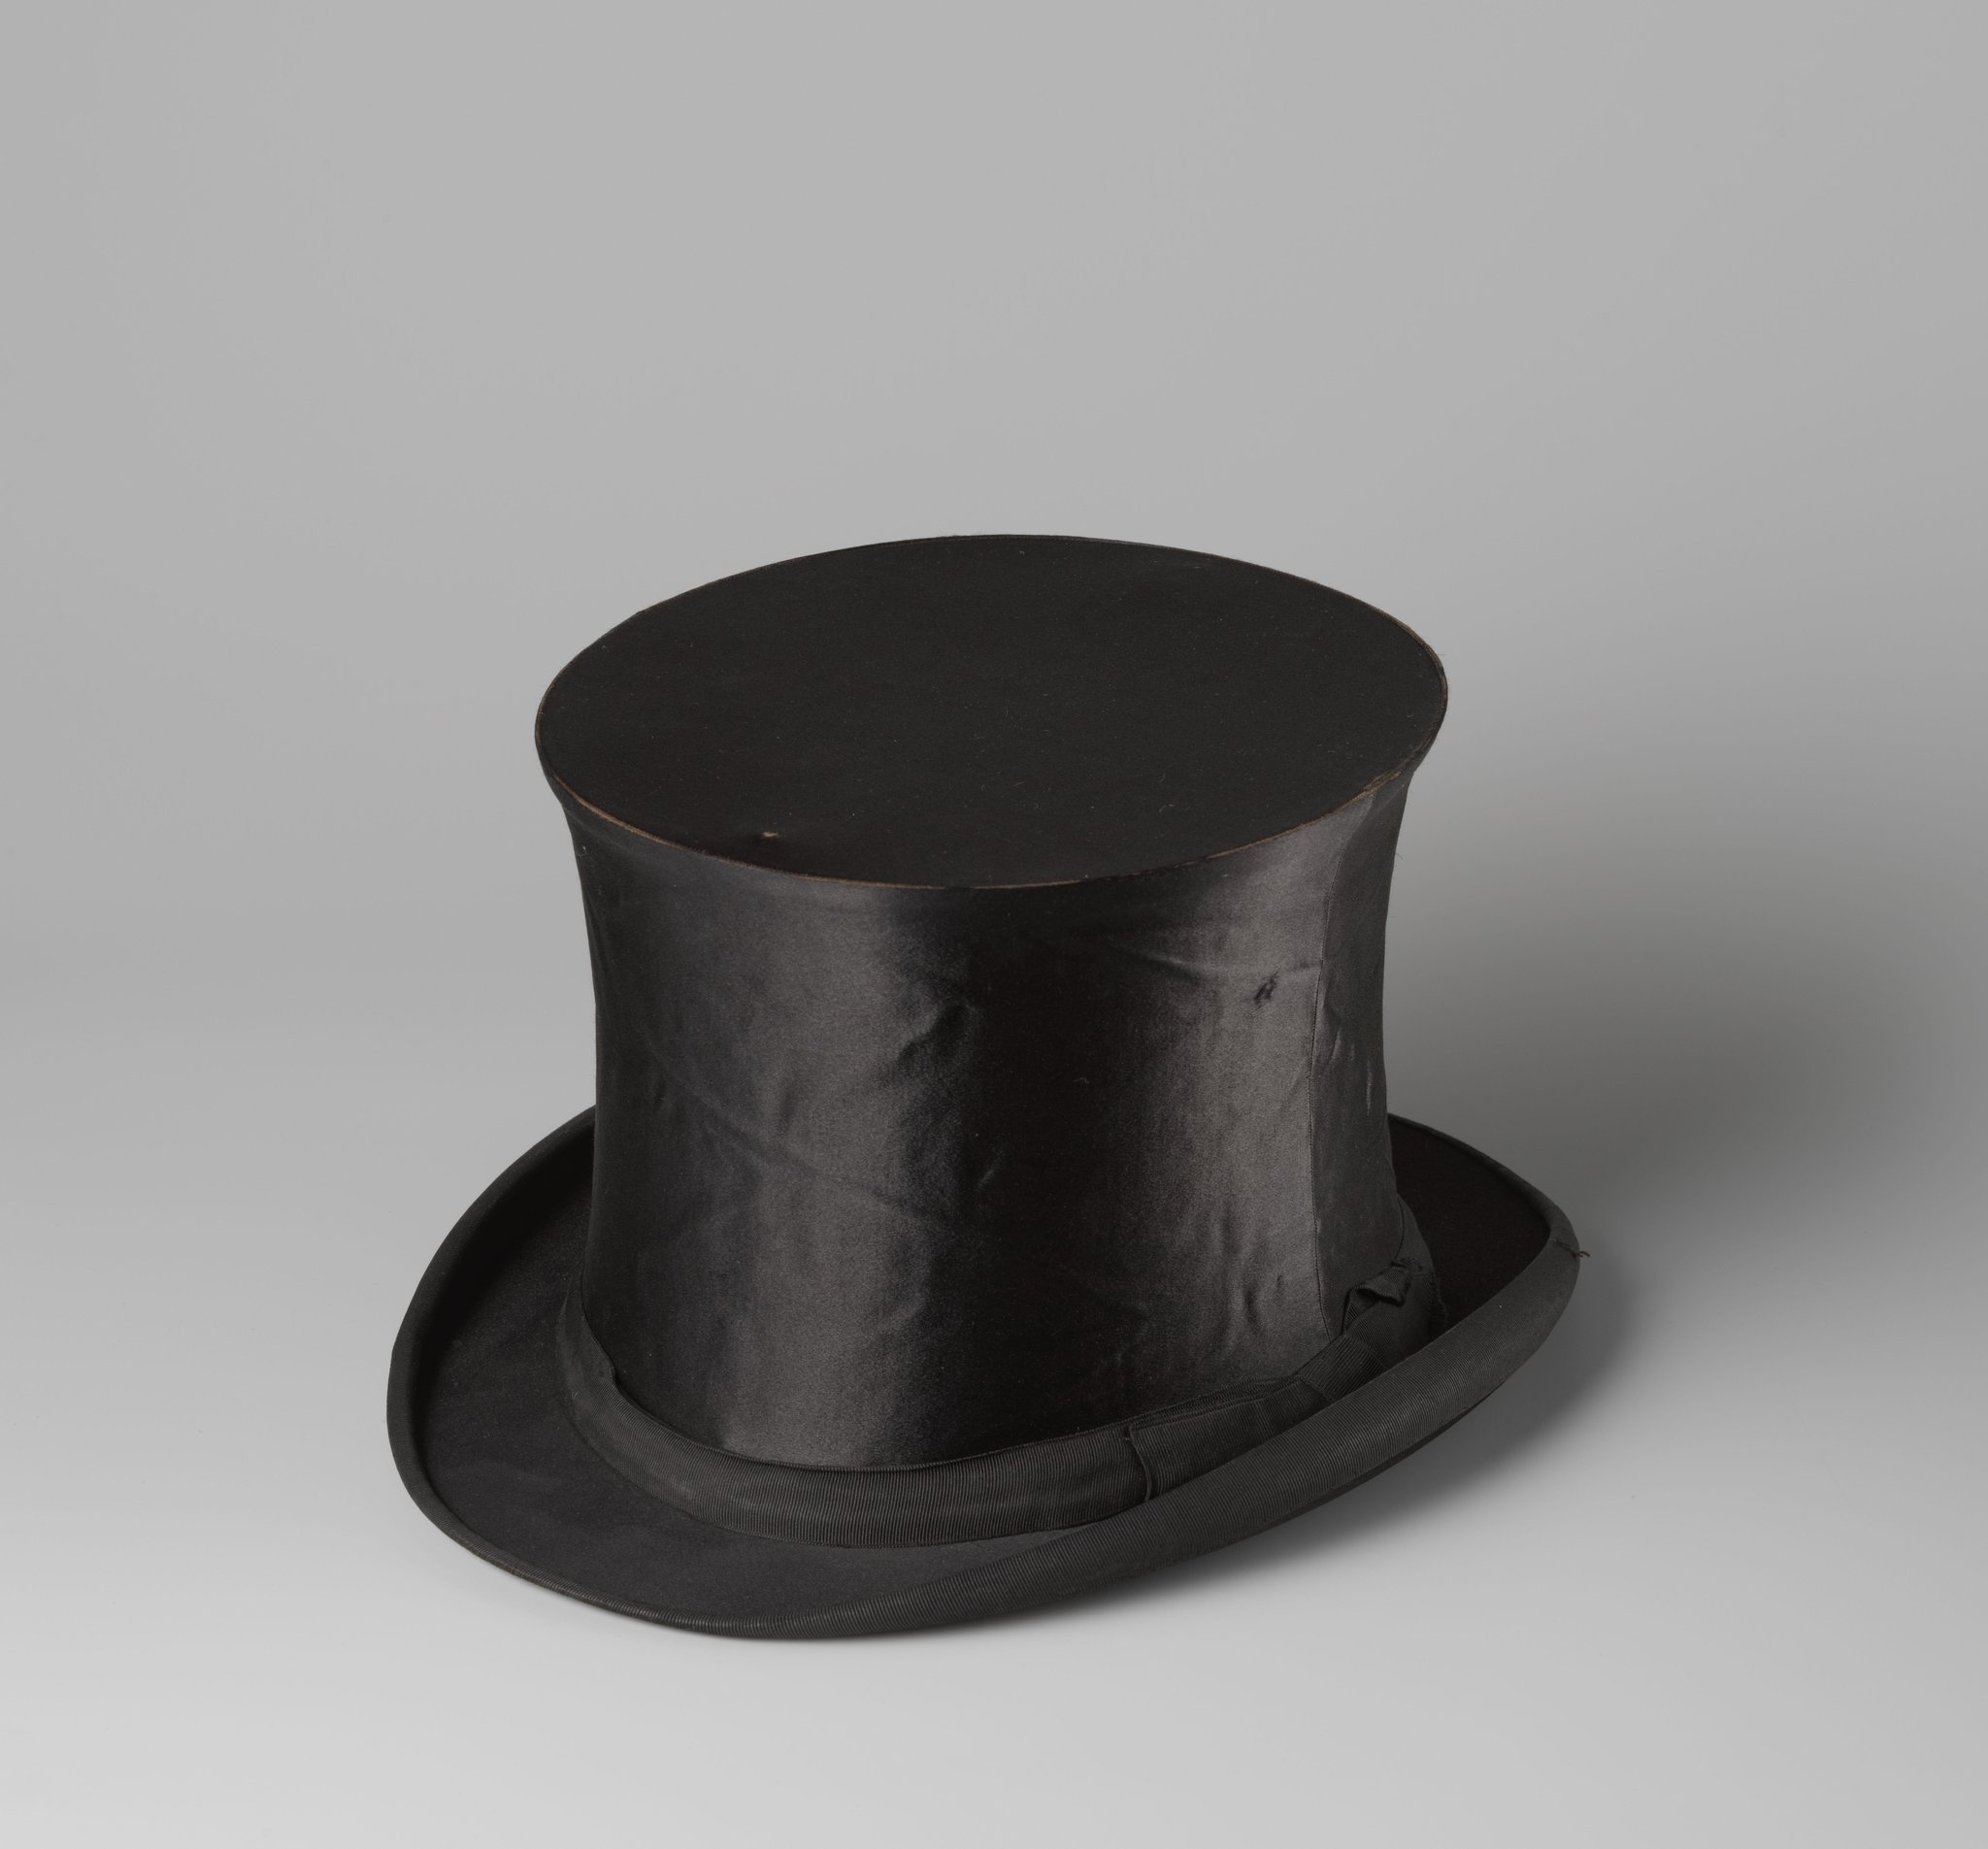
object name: chapeau claque, claque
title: Hoge hoed van zwart satijn, zogenaamde claque, met veermechaniek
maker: alexander ferdinand herbermann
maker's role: directeur, hoedenmaker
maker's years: 1863-1932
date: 1888-1896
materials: textile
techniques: rib binding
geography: amsterdam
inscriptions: factory mark: ‘M.ture de CHAPEAUX MECANIQUE(S) // CC als monogram in cirkel // MARQUE DE FABRIQUE.’, address: ‘A.F. HERBERMANN // Koningsplein 14 // AMSTERDAM.’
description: Hoge hoed, chapean claque, van zwart satijn. Bol, iets gehold cylindrische. Opklapbaar door een ingebouwde veer. Rand. Smal, alleen opzij op wippend. Omboord met risplint, waarvan ook het hoedenlint is. Voering. Zwart satijn. Merk. Ovaal, M.ture de CHAPEAUX MECANIQUE(S) / CC als monogram in cirkel naast een cirkel met enige voorstelling / MARQUE DE FABRIQUE Adres A.F. HERBERMANN / Koningsplein 14 / AMSTERDAM. Beide in goud gedrukt. Doos. Karton met donkerpaars papier met merk: MANUFACTURE DE PARIS CHAPEAUX MECANIQUES PERFECTIONNE'S / GEKROOND Wapen van Parijs.